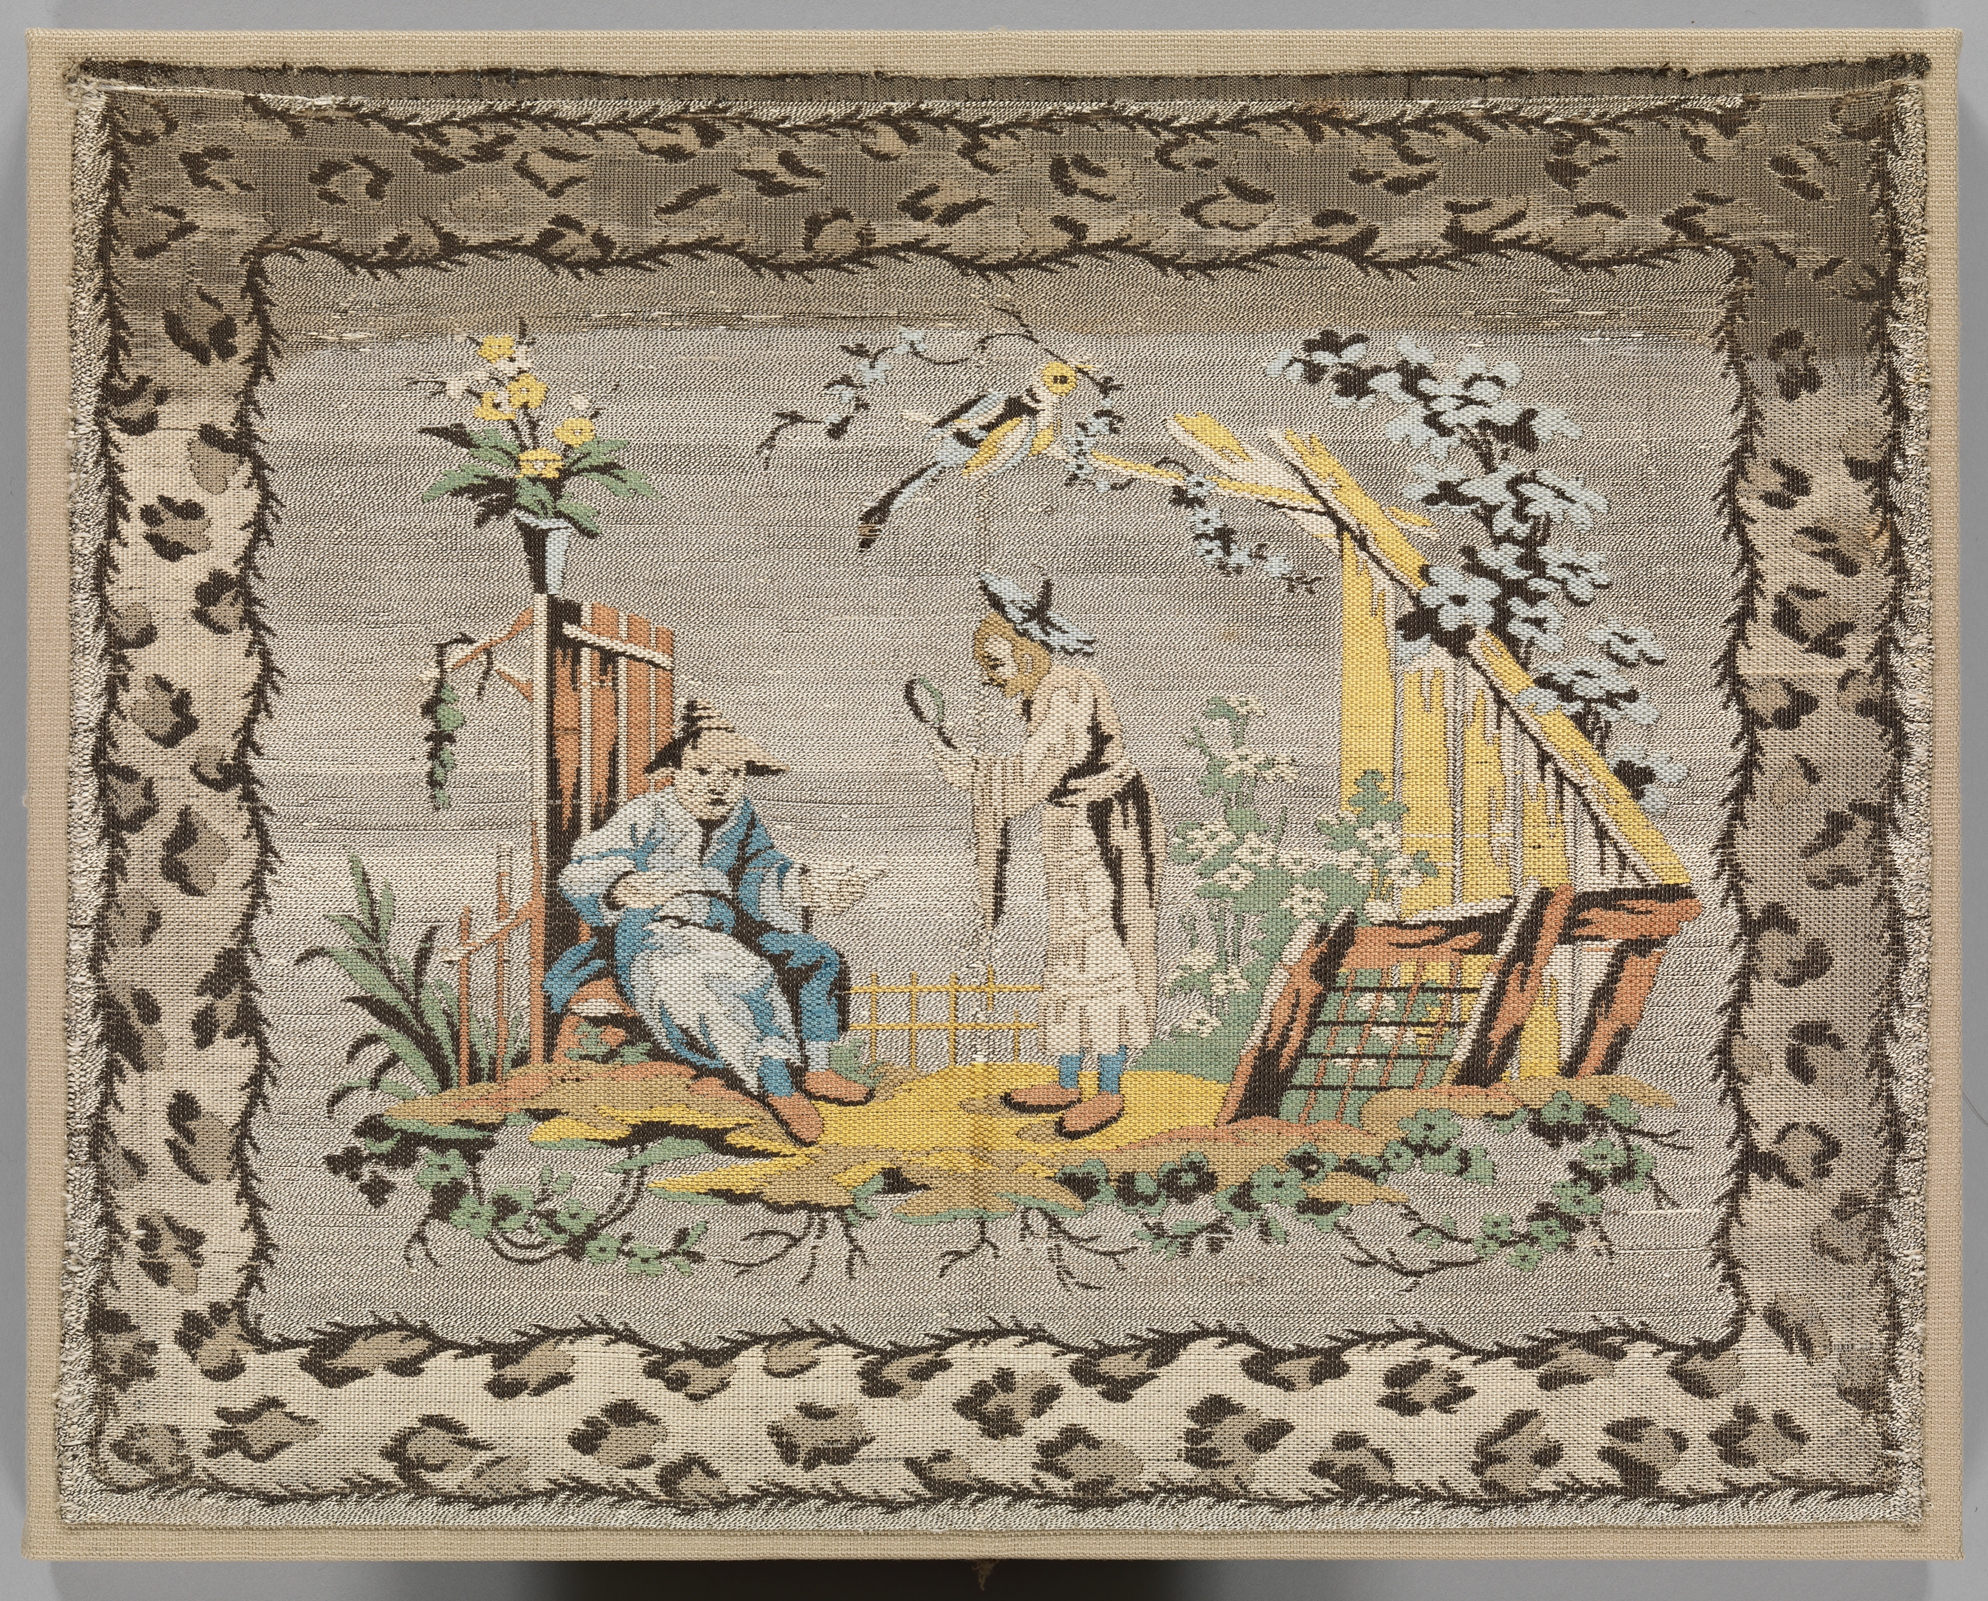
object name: piece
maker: jean pillement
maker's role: artist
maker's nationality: french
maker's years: 1728-1808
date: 1751-1800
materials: metal thread, silk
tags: birds,men,flowers